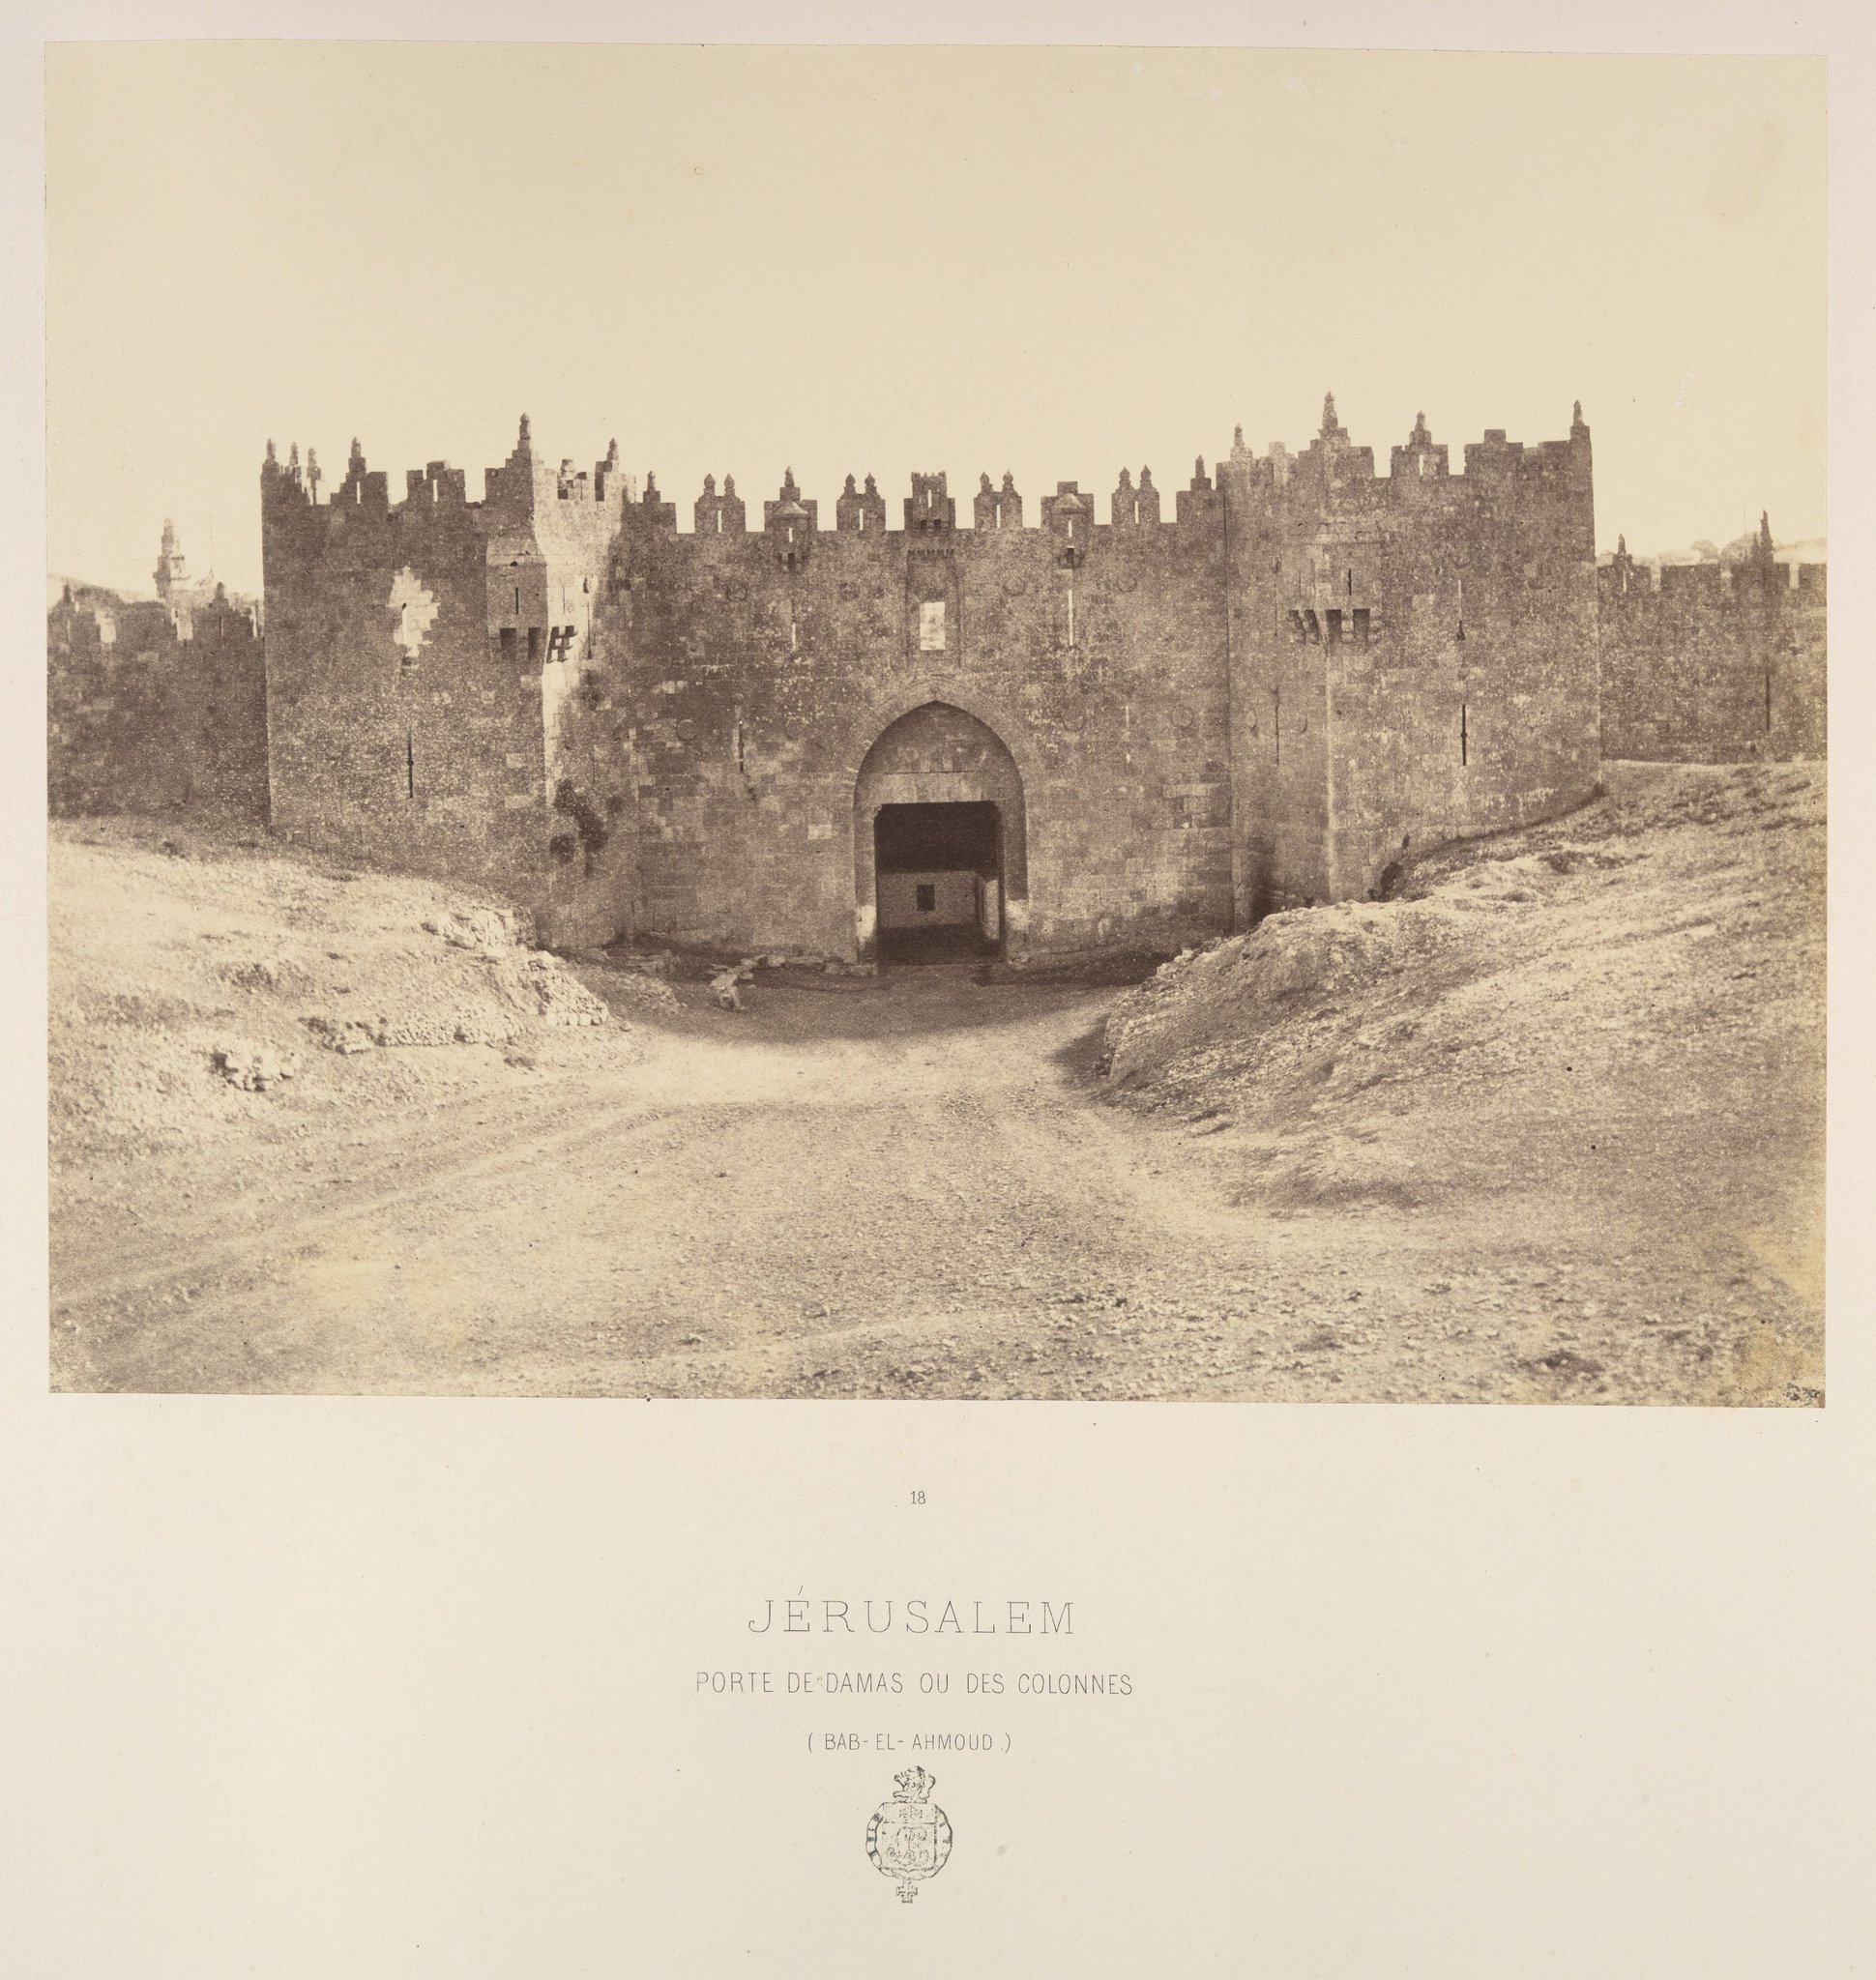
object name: photograph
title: Jérusalem. Porte de Damas ou des colonnes (Bab-el-Ahmoud)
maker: louis de clercq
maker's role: artist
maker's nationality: french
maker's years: 1837-1901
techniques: albumen silver print, paper negative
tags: architecture,arches,gates